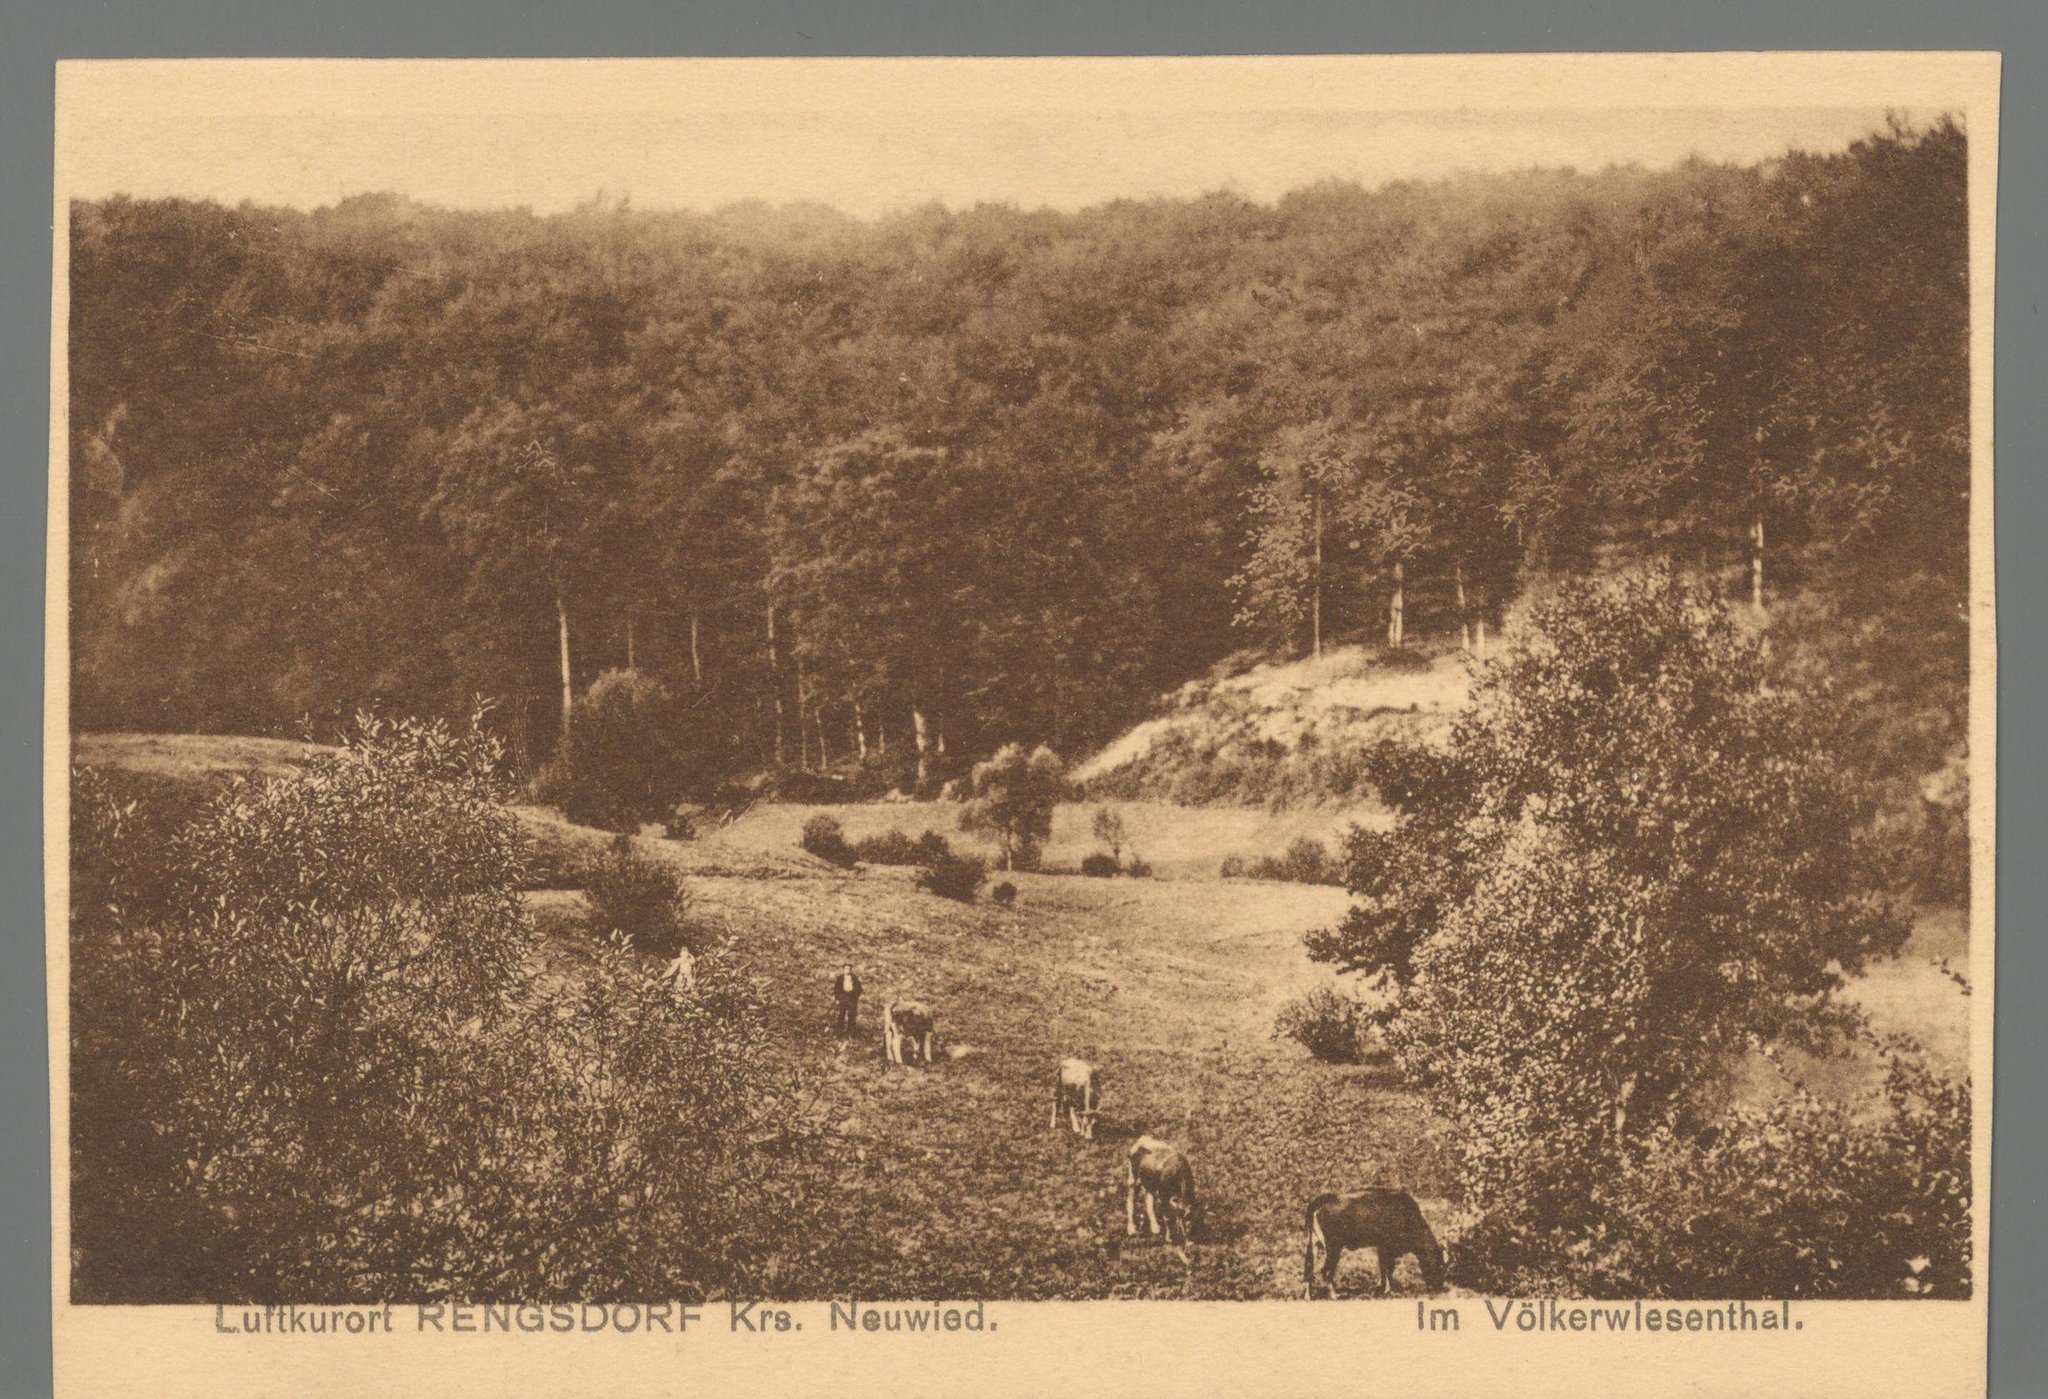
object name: photomechanical print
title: Luftkurort Rengsdorf, Krs. Neuwied. Im Völkerwiesenthal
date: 1905-1930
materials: cardboard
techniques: photograph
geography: rengsdorf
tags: dale, valley, watering-place, spa